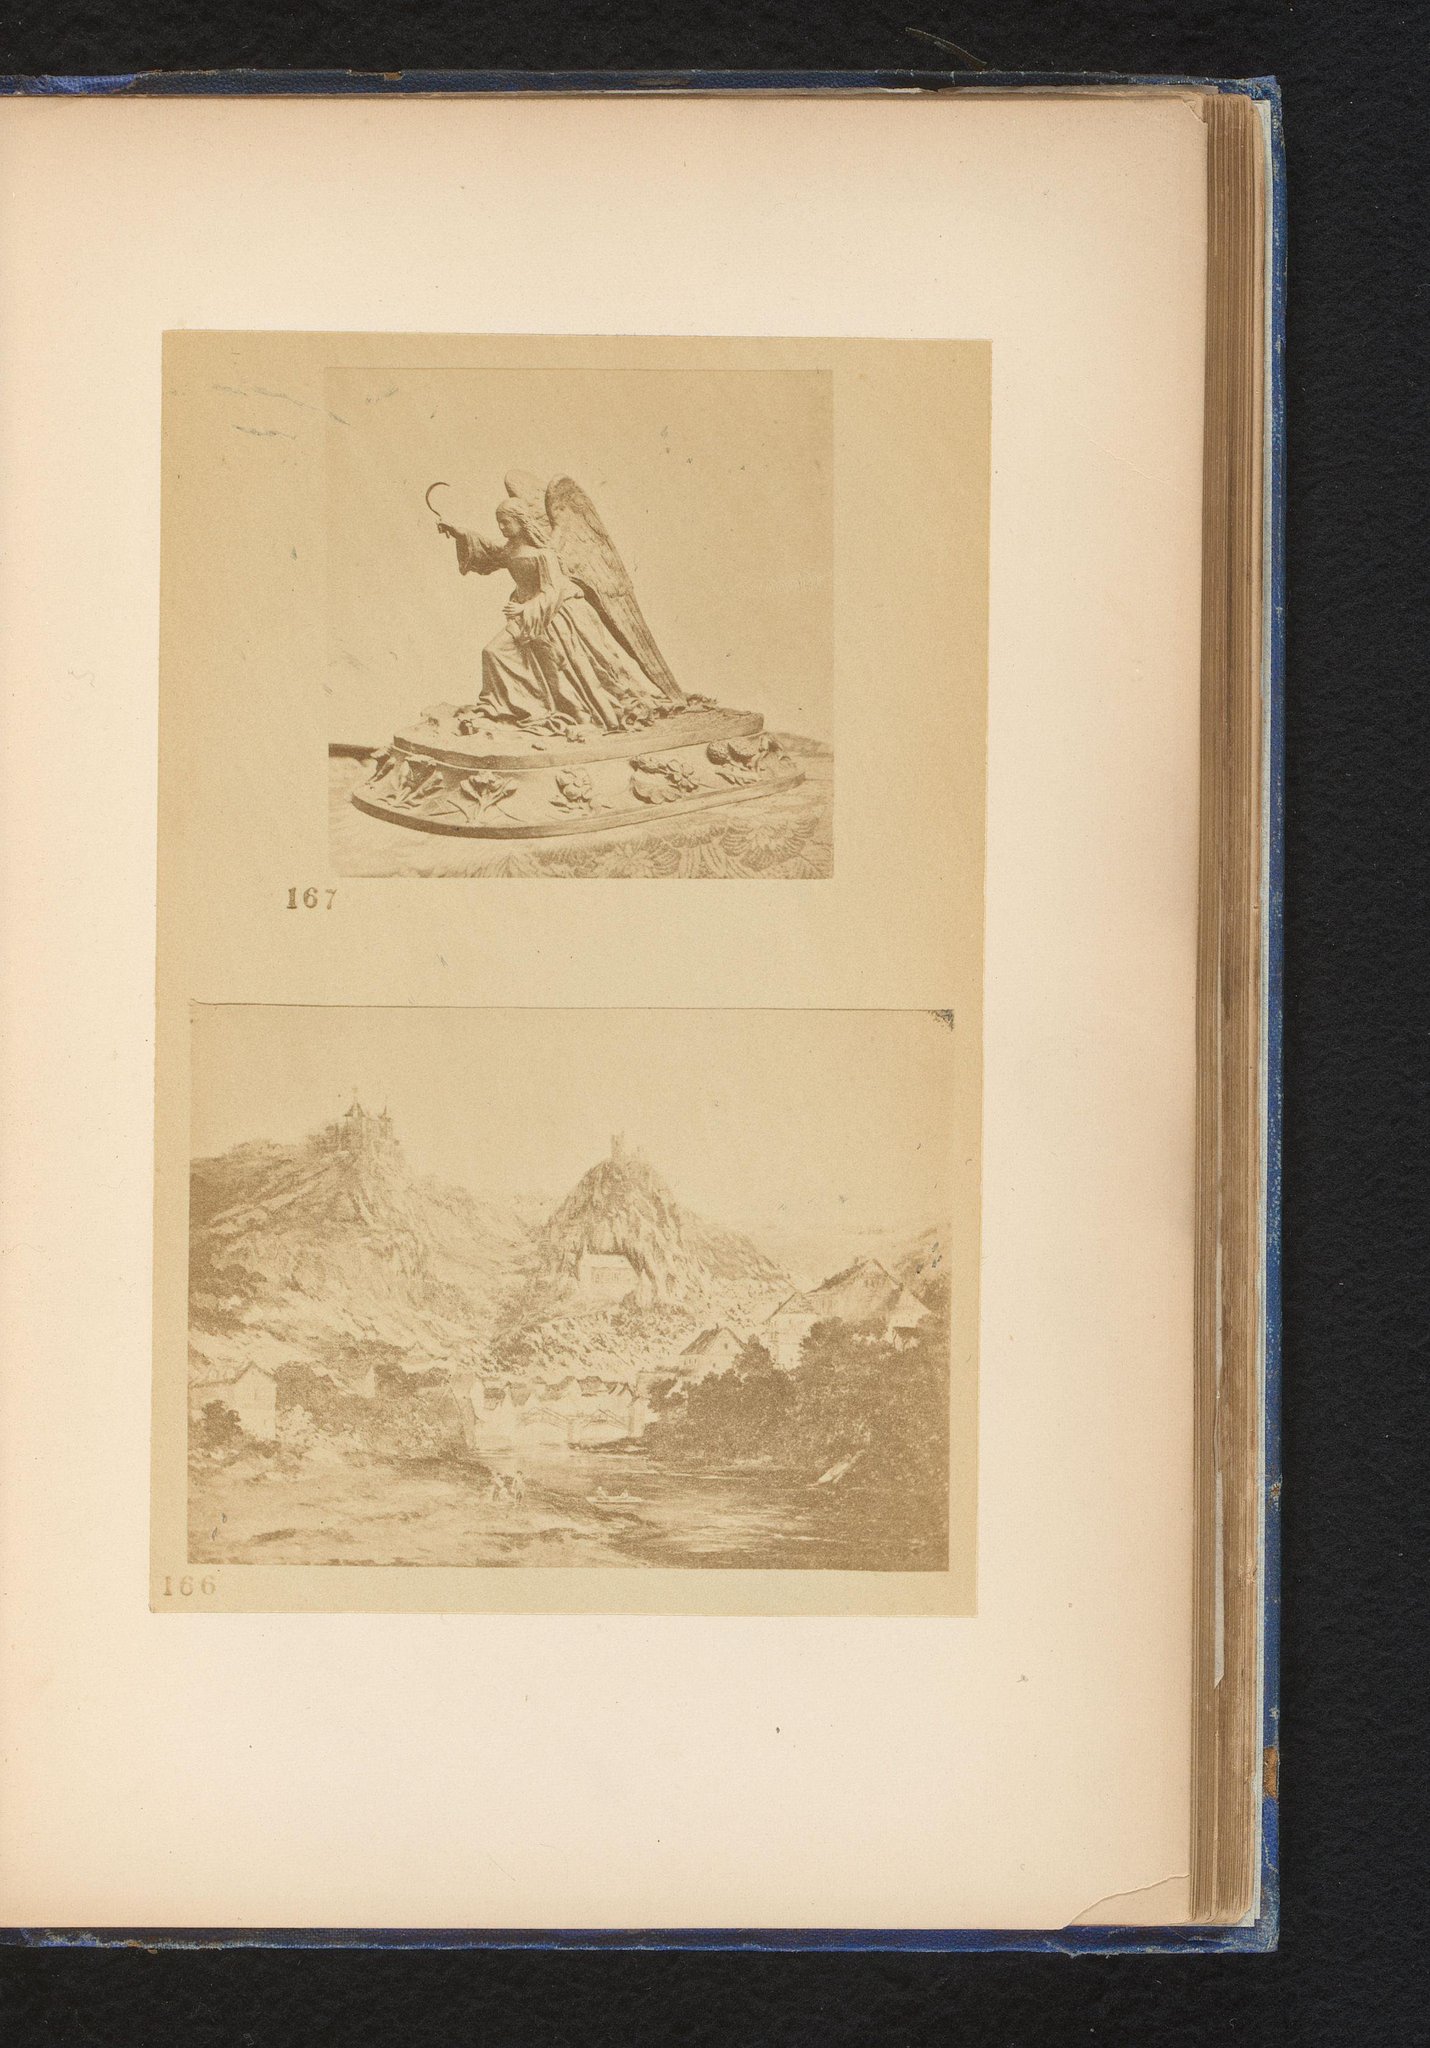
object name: photograph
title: Zonnewijzer in de vorm van een engel en een schilderij met een gezicht op Idar-Oberstein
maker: f. cole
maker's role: fotograaf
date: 1862-1867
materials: paper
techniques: albumen print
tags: city-view in general; 'veduta', sundial, angels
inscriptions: number: ‘166, 167’